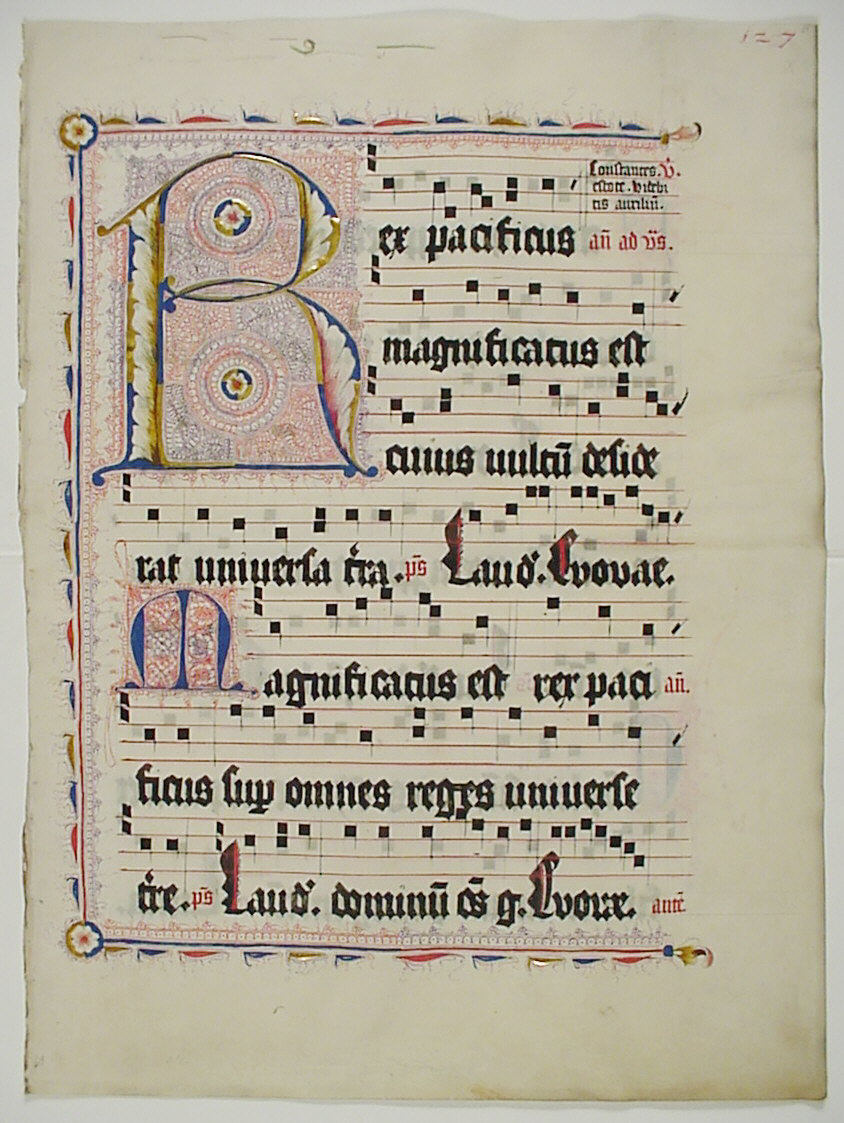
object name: antiphonary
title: Manuscript Leaf with Initial R, from an Antiphonary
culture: german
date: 1426-1450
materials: ink, metal leaf, parchment, paint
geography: germany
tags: music